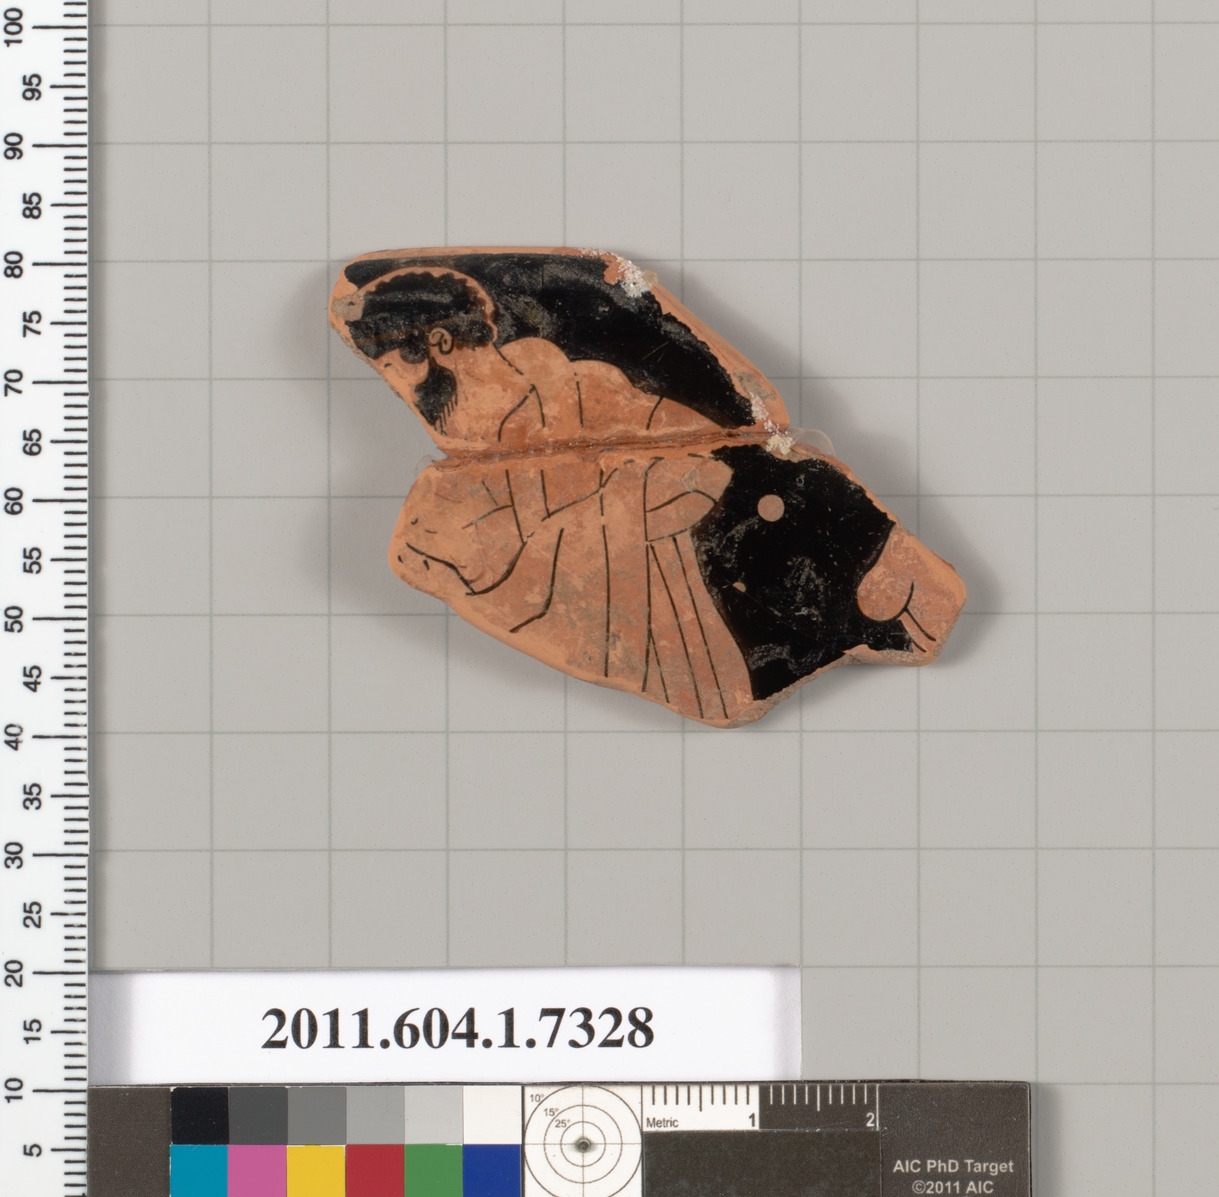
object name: kylix fragment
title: Terracotta rim fragment of a kylix (drinking cup)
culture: greek, attic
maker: makron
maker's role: artist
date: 500-480 BCE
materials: terracotta